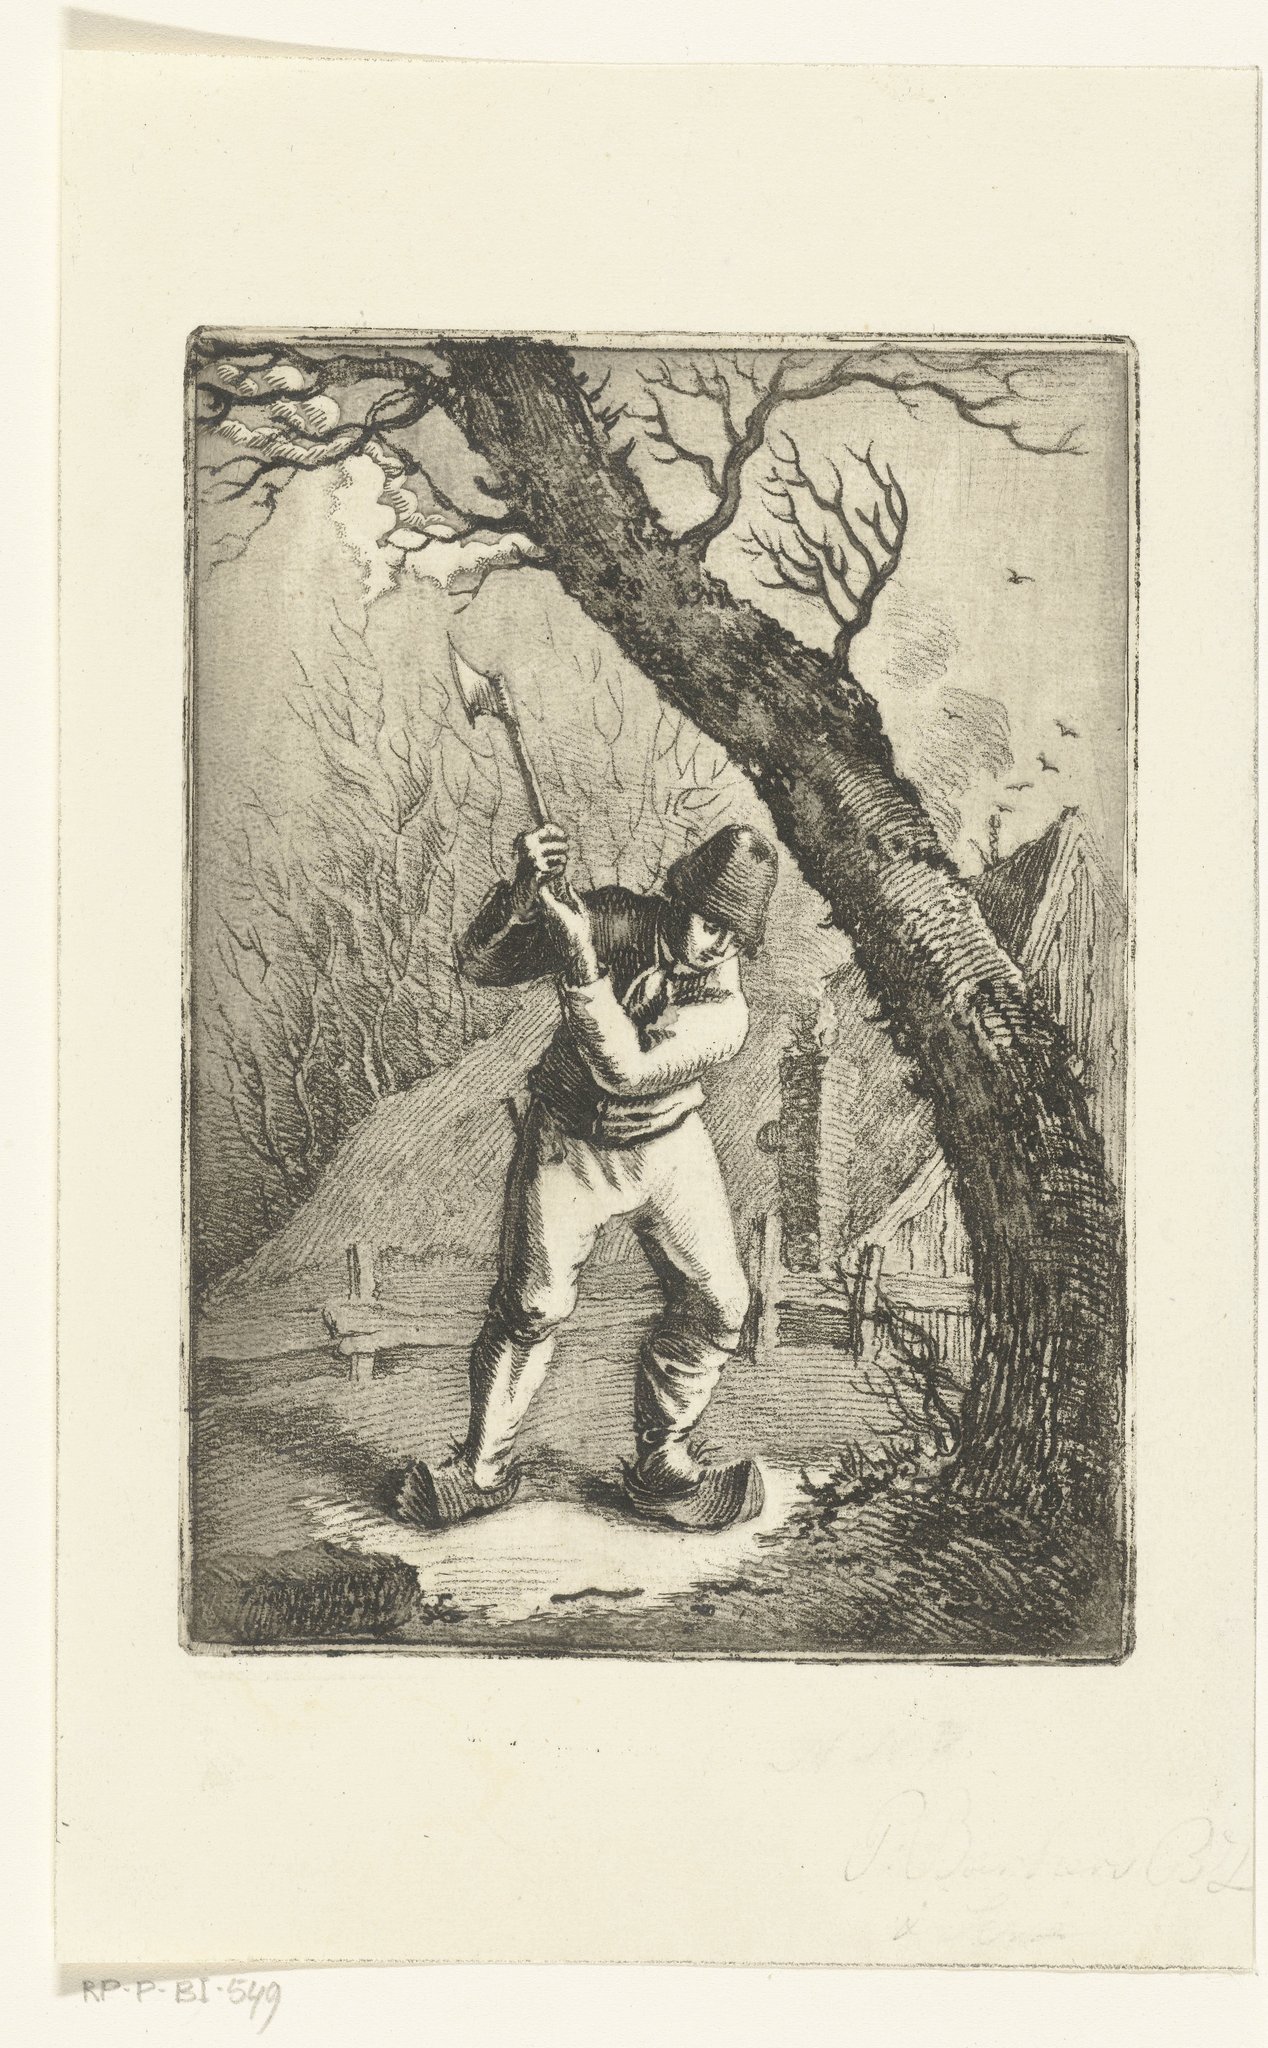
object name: print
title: Man met bijl bij boom voor boerderij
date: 1782-1837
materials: paper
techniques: aquatint, soft ground etching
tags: tools, aids, implements ~ crafts and industries: axe, farm or solitary house in landscape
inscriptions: collector's mark: Lugt 2228